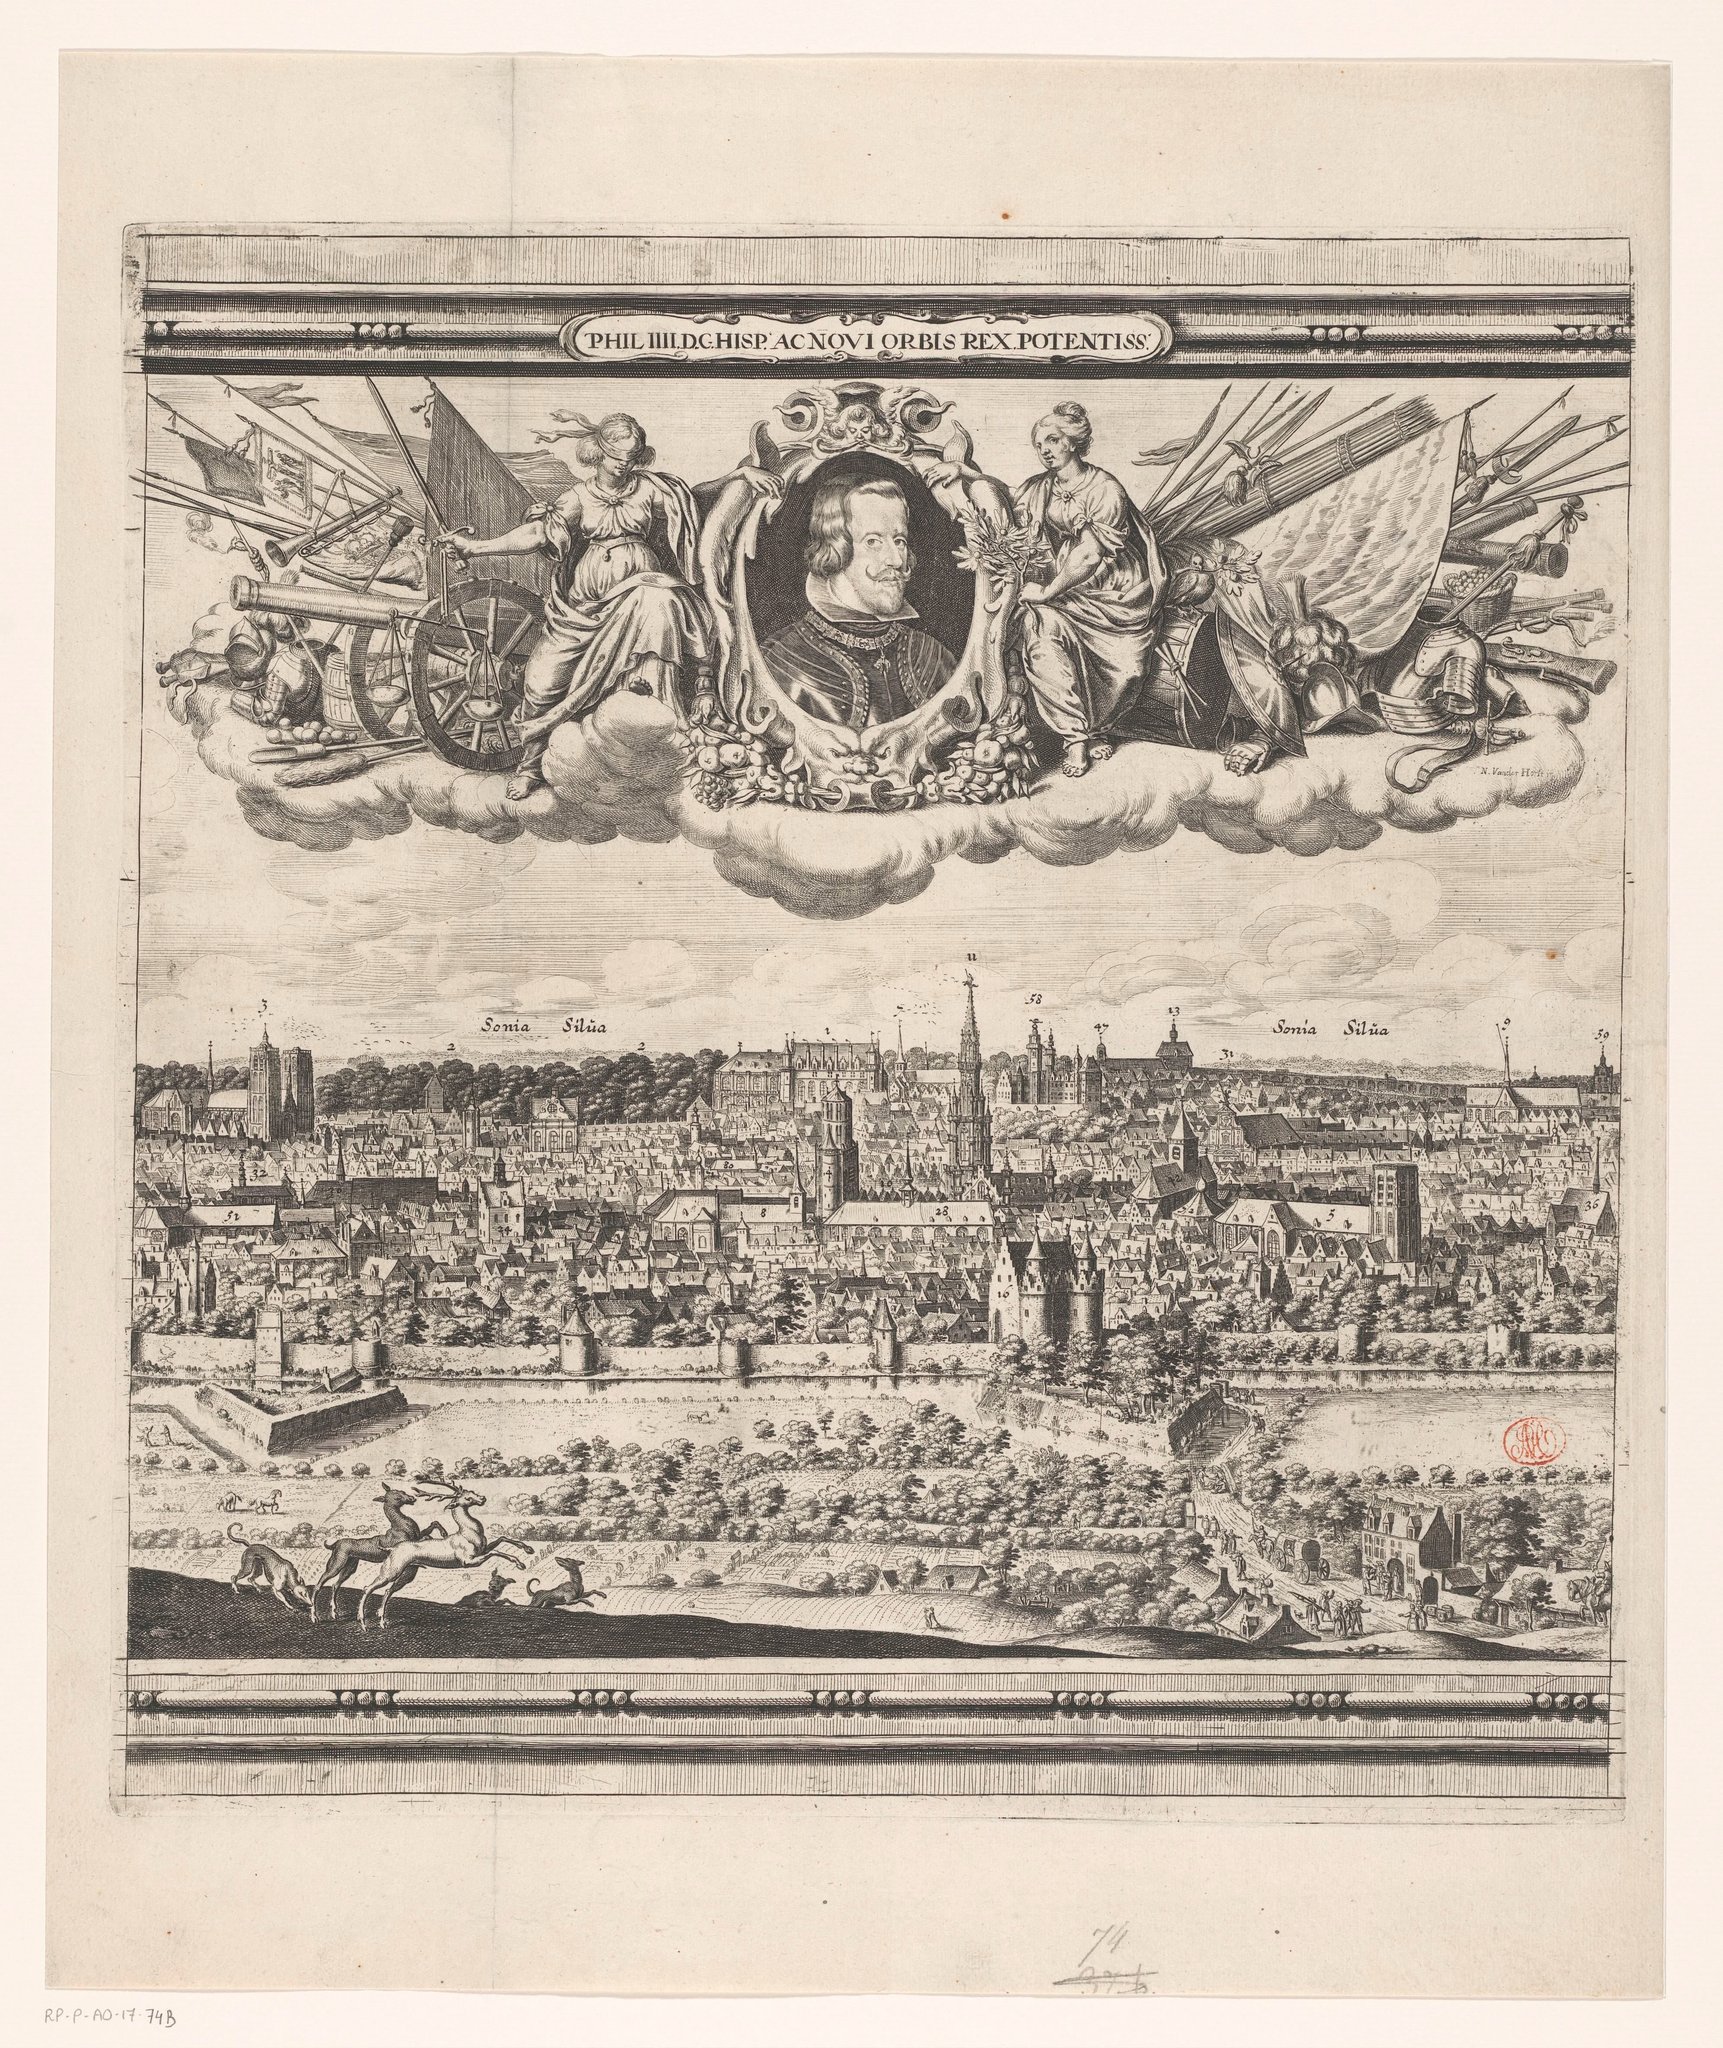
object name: print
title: Gezicht op Brussel (middelste deel)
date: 1640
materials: paper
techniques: engraving, etching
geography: brussels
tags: filips iv (koning van spanje), armour (+ weapons), hoofed animals: deer, justitia (justice) as roman personification, church (exterior), fortified city, prospect of city, town panorama, silhouette of city, brussels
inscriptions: collector's mark: Lugt 195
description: Onderdeel van het stadsgezicht van de tweede uitgave (1748) van een wandkaart van Brussel, getiteld 'Bruxella nobilissima Brabantiae civitas restauratum ano 1748'. Deze wandkaart bestond uit een plattegrond (gedrukt van zes platen, zie: RP-P-AO-17-73) met daaronder of daarboven dit stadsgezicht (gedrukt van drie platen, zie: RP-P-AO-17-74), met langs de zijkanten een beschrijving van de stad en gezichten op gebouwen. De eerste uitgave verscheen in 1640 onder de titel 'Bruxella nobilissima Brabantiae civitas ano 1640'.